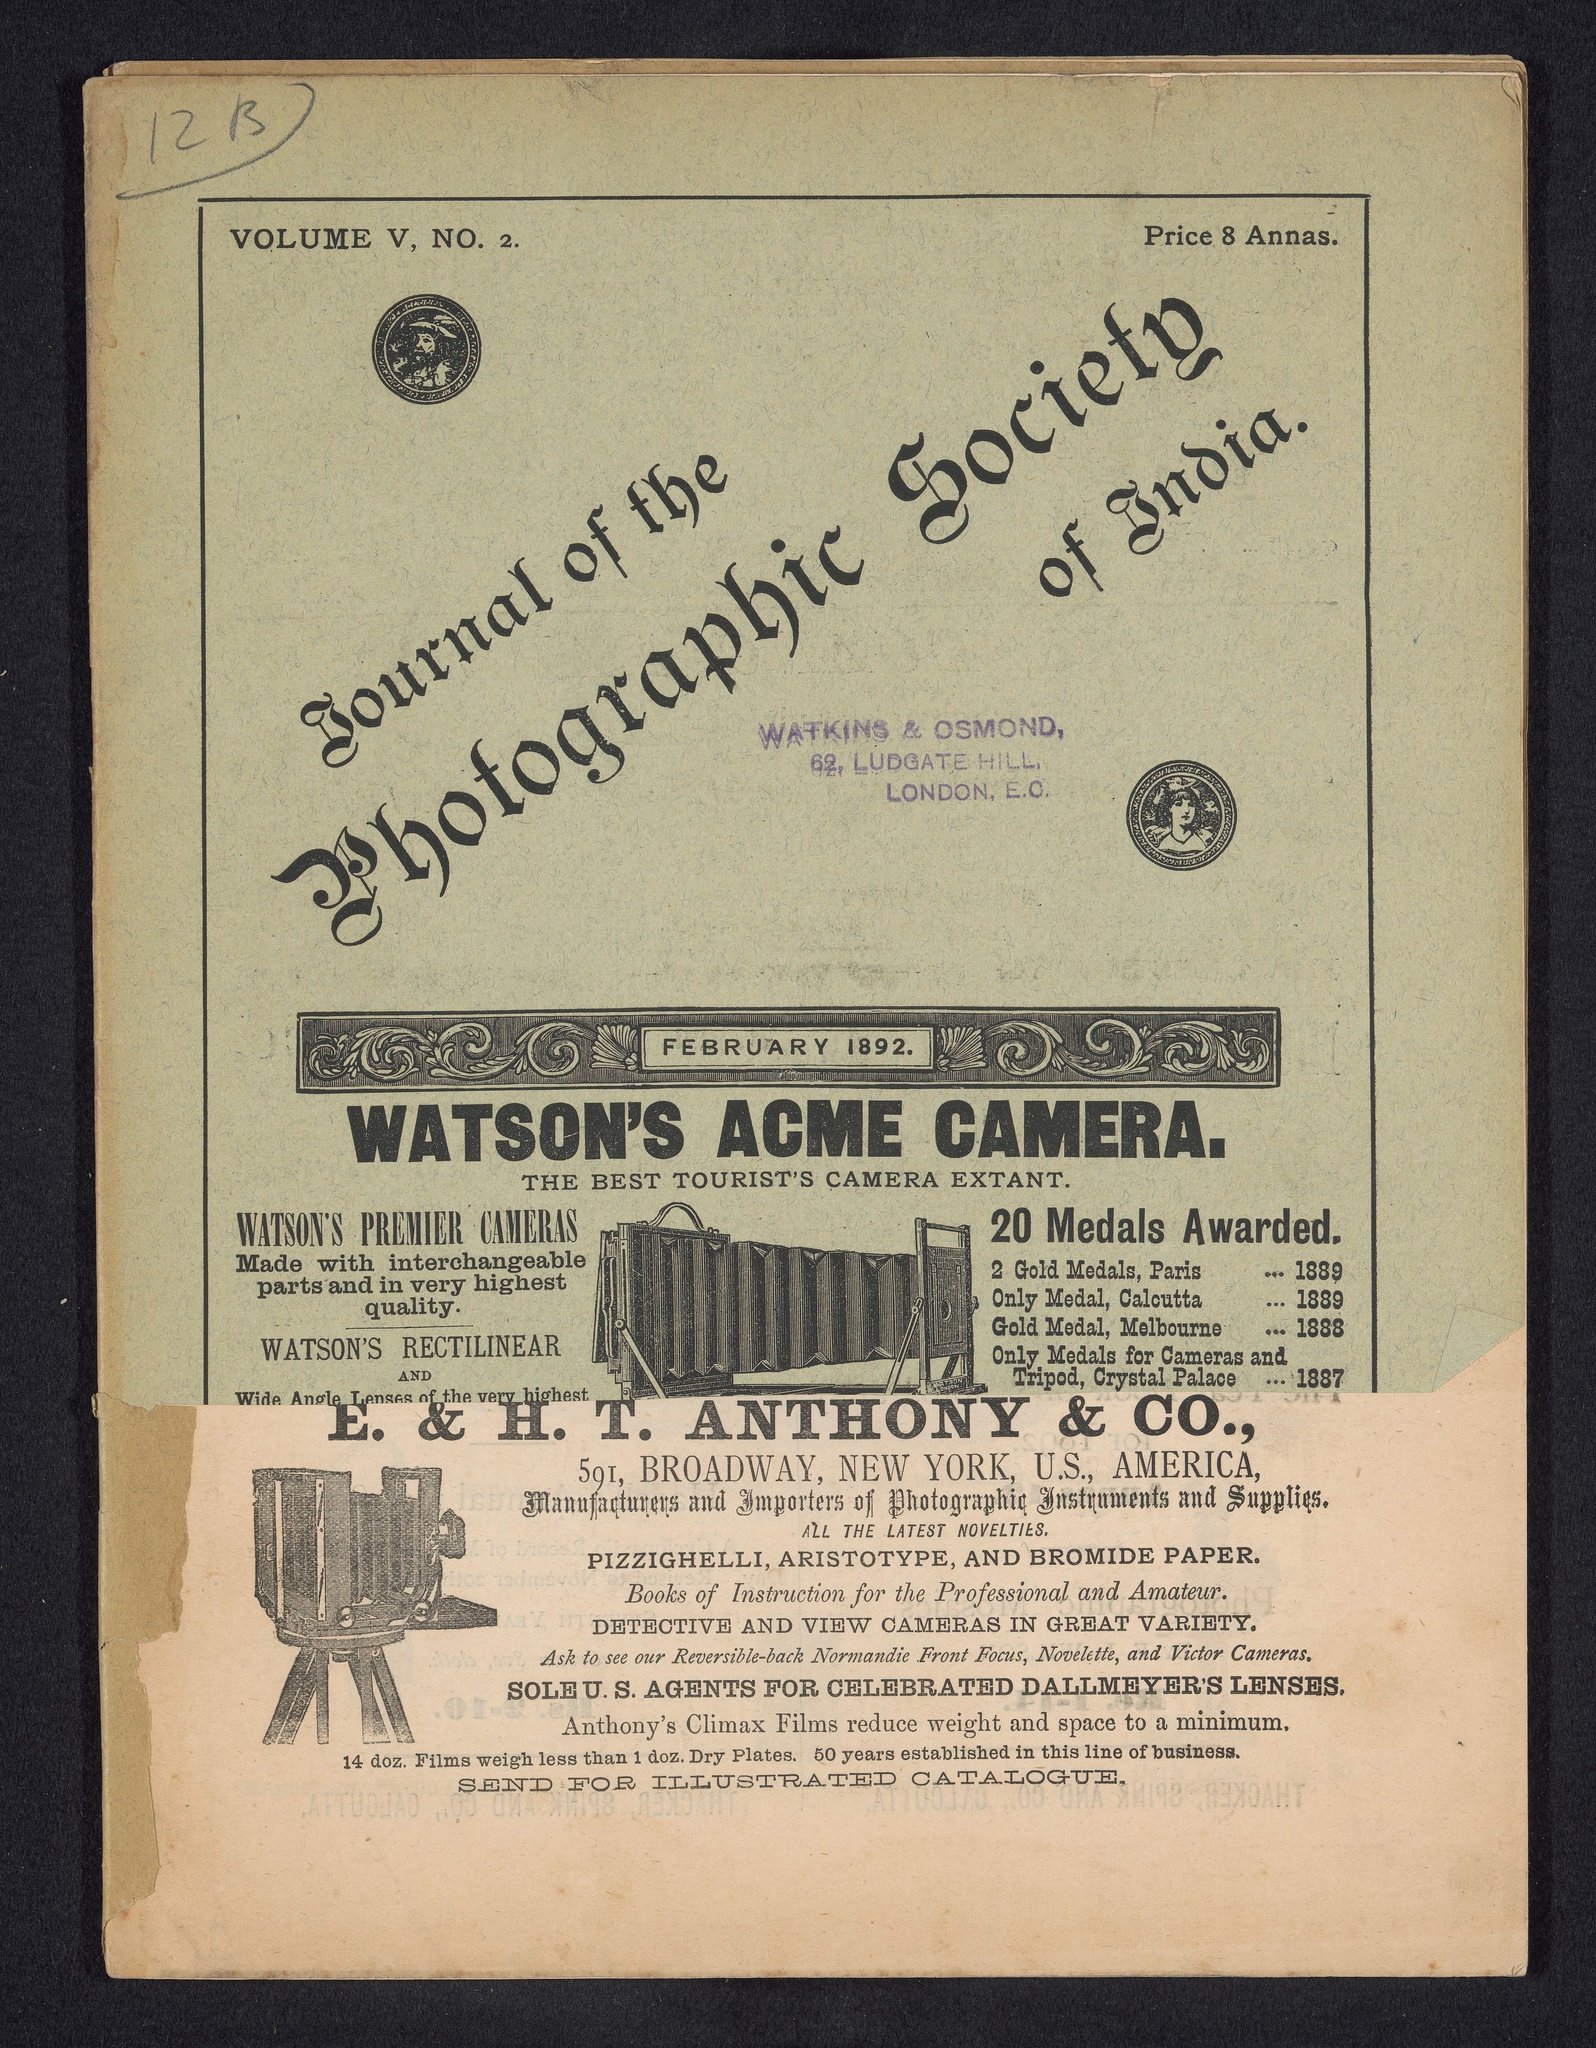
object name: book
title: The journal of the Photographic Society of India Volume V. No.2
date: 1892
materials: paper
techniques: photograph, printing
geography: kolkata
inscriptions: name: ‘Watkins & Osmond. 62, Ludgate Hill, London, E.C.’